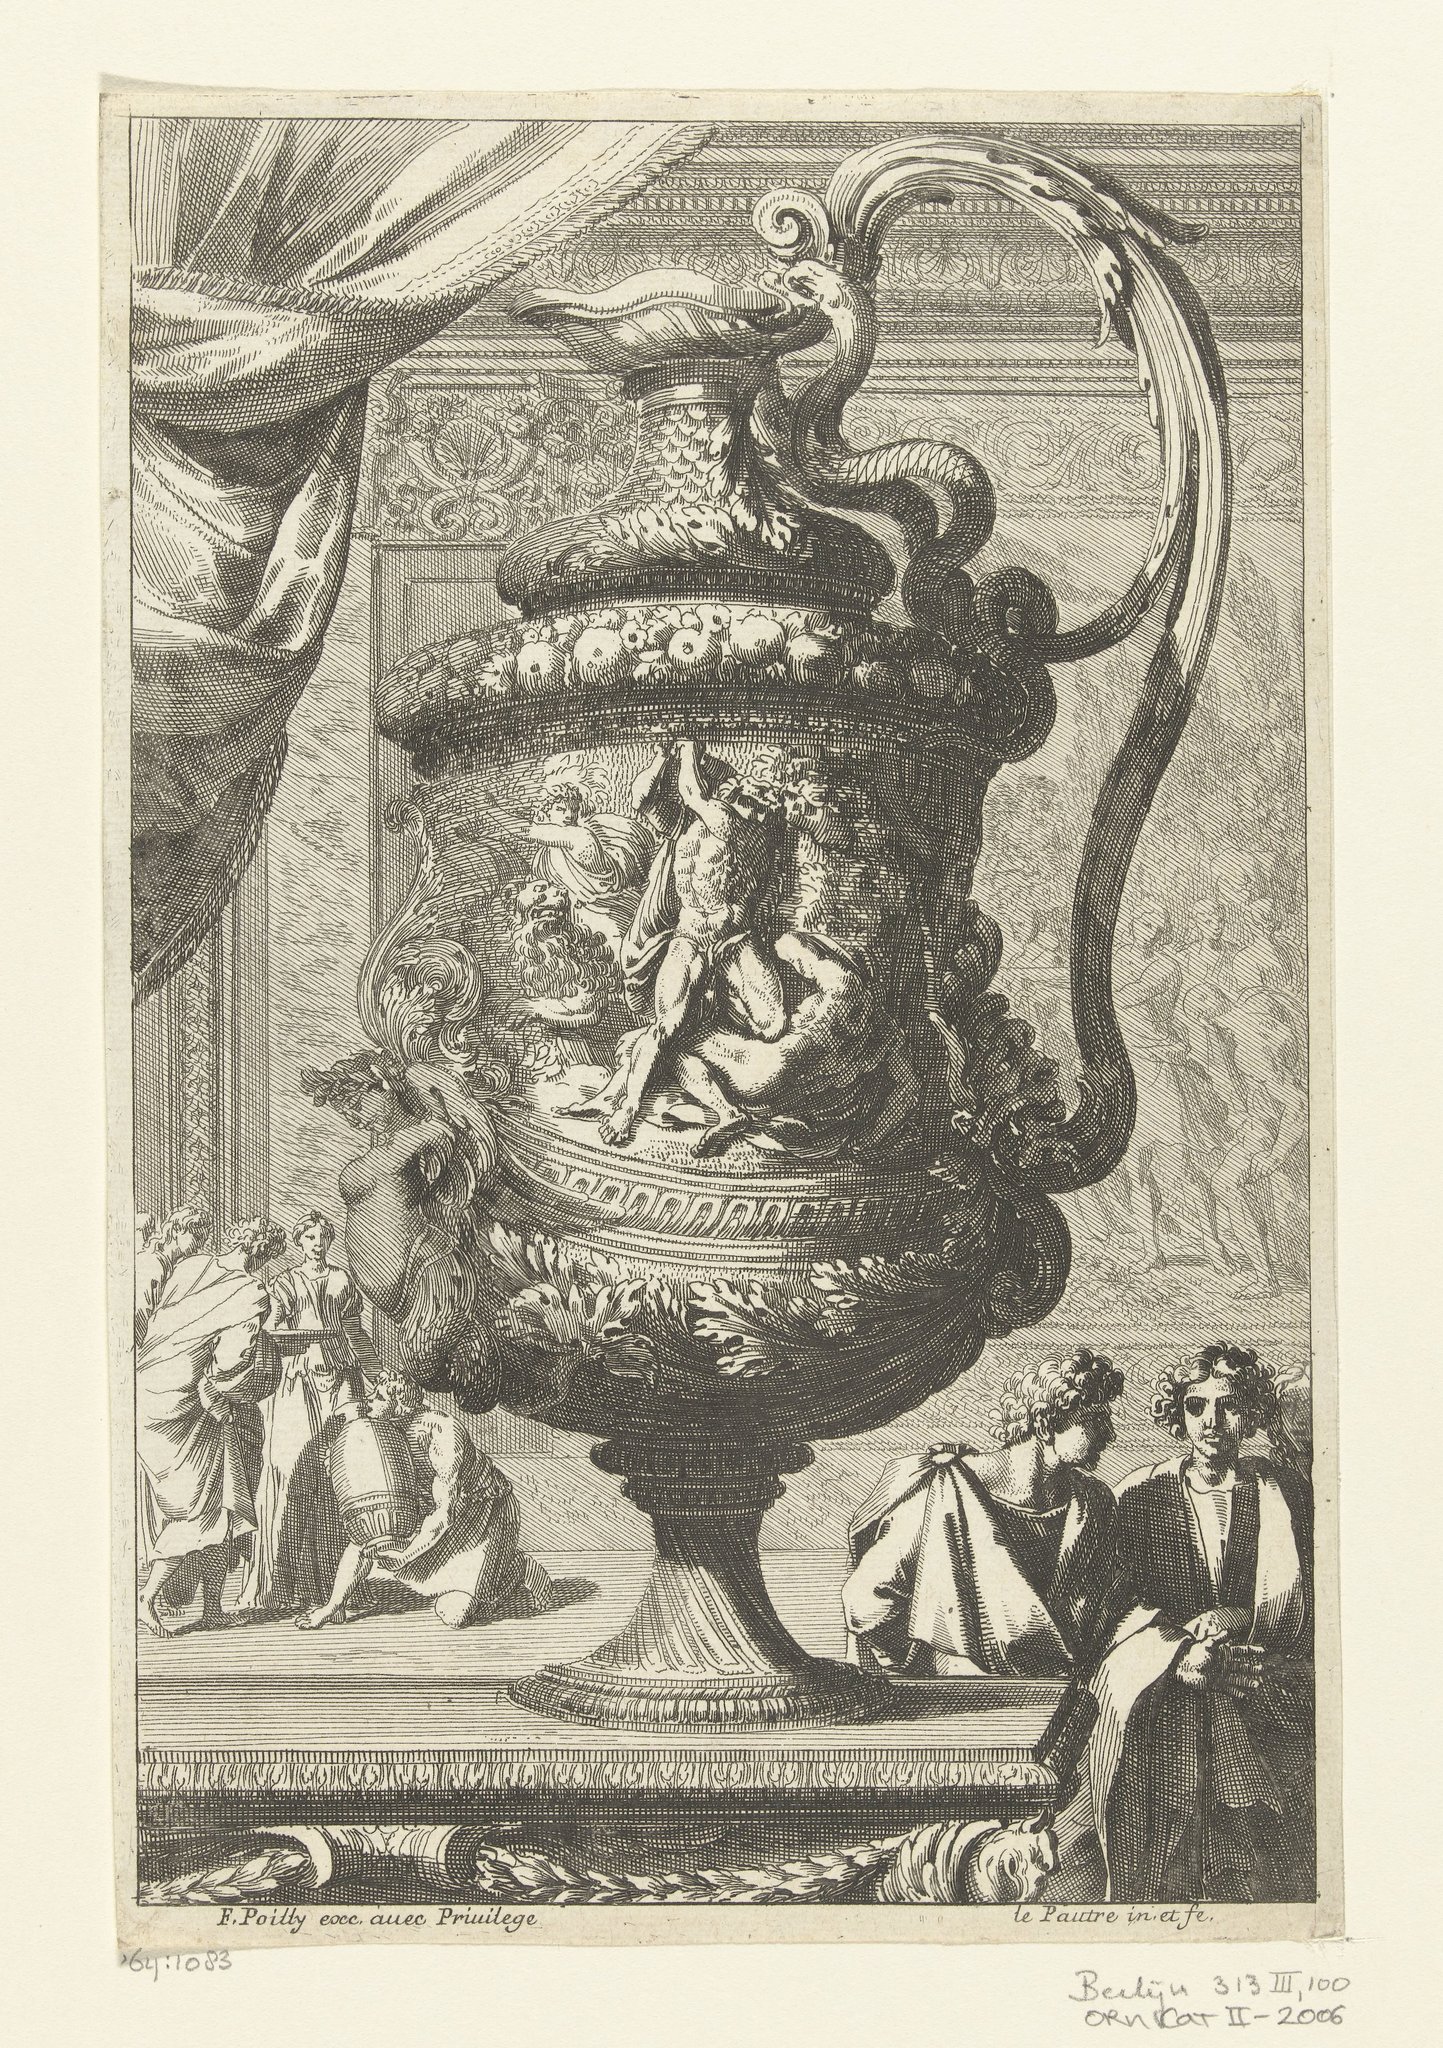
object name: ornament print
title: Vazen en schenkkannen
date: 1669-1693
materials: paper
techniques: etching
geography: france